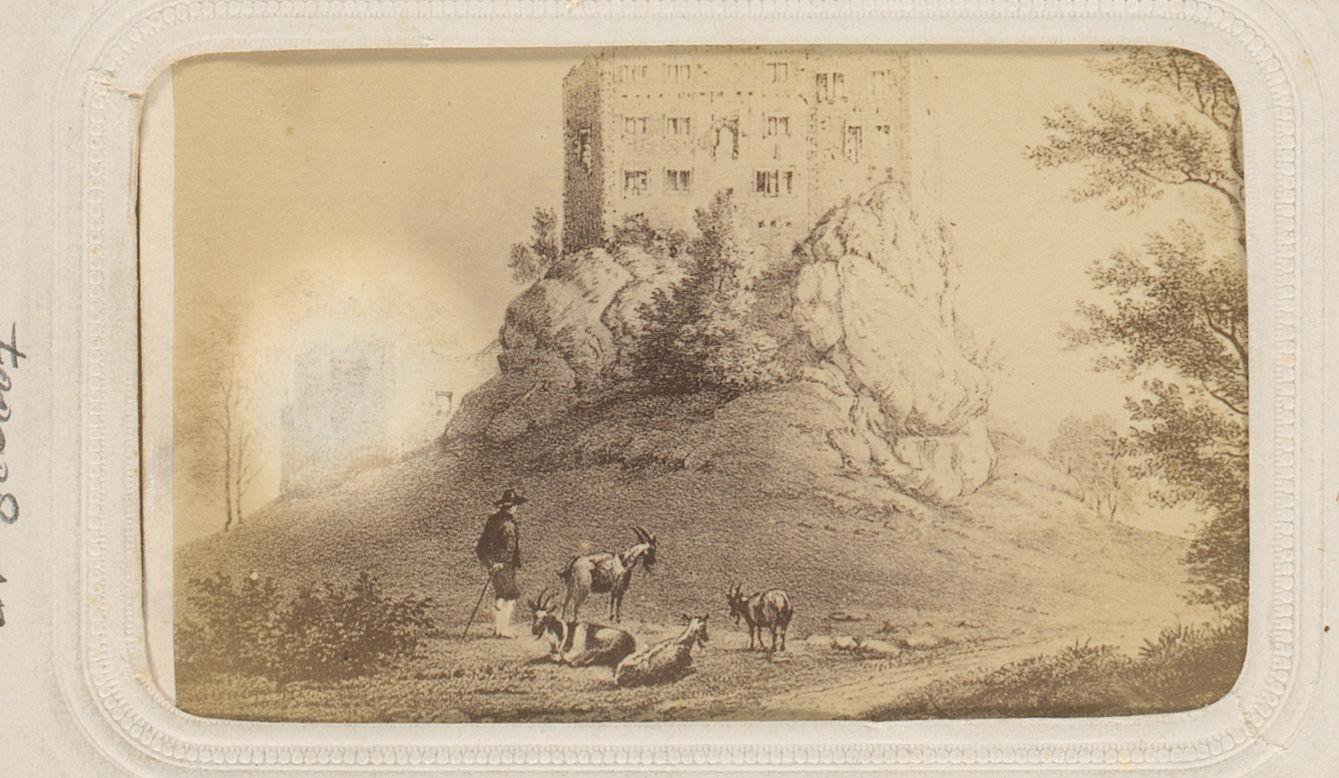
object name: reproduction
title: Fotoreproductie van een prent van Burg Liebenstein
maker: Anonymous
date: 1860-1885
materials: cardboard, photographic support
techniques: albumen print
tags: herding, herdsman, herdswoman, shepherd, shepherdess, cowherd, etc., (high) hill, ruin of a dwelling, house, castle, etc.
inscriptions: annotation: ‘Burgstein bij Liebestein’, annotation: ‘Burgstein bij Liebestein’, inscription: ‘Alte Burg Liebenstein, v. West’